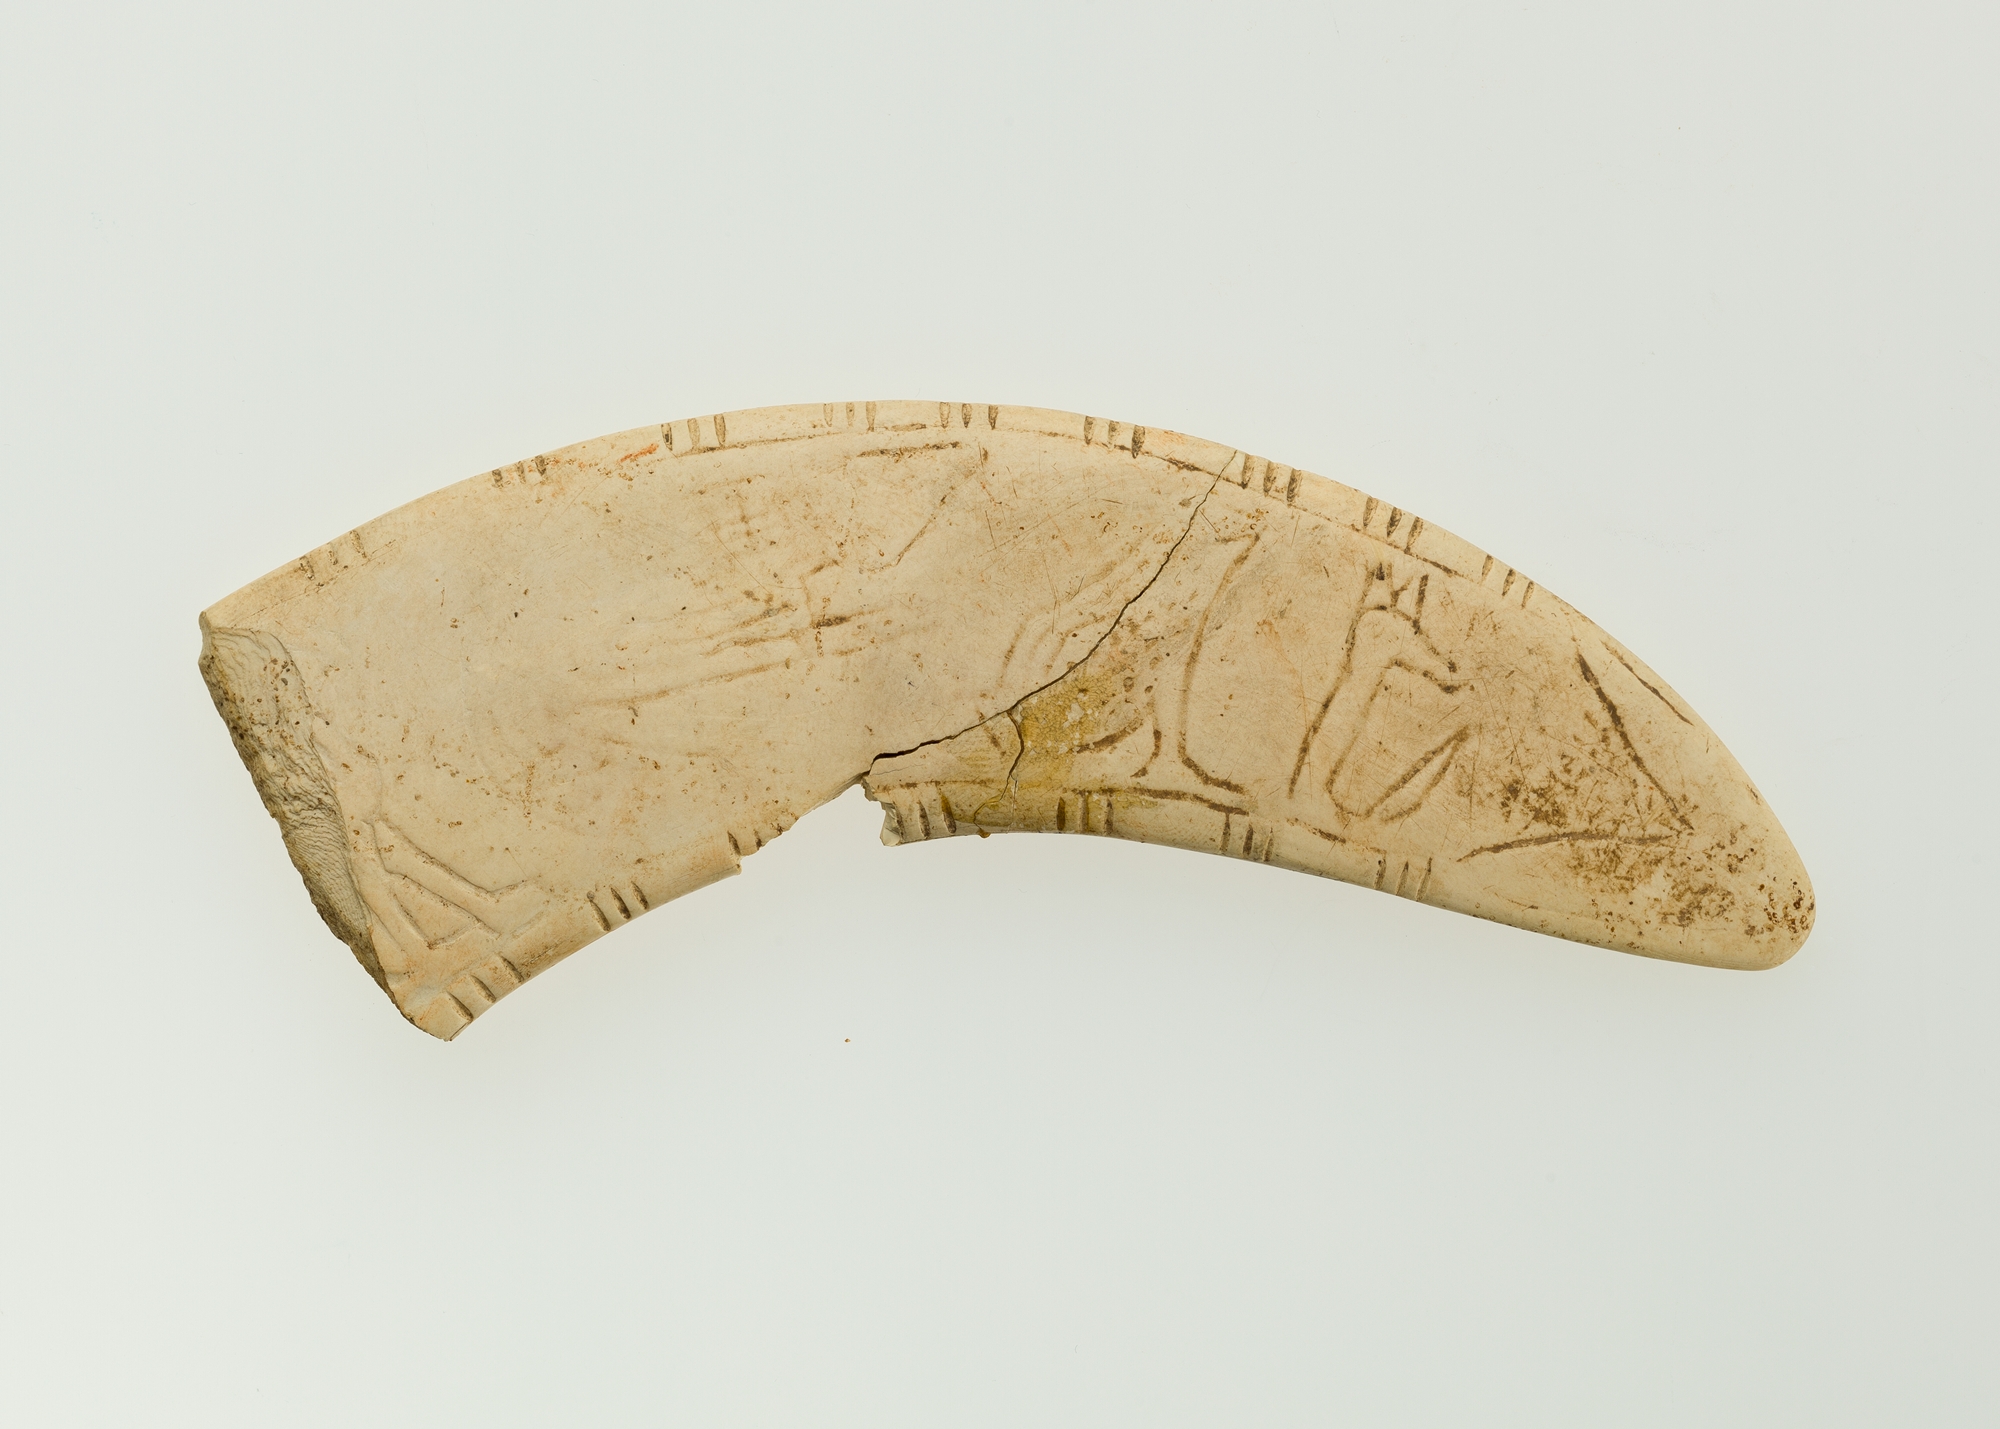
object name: magic wand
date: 2124-1504 BCE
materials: ivory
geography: egypt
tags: animals